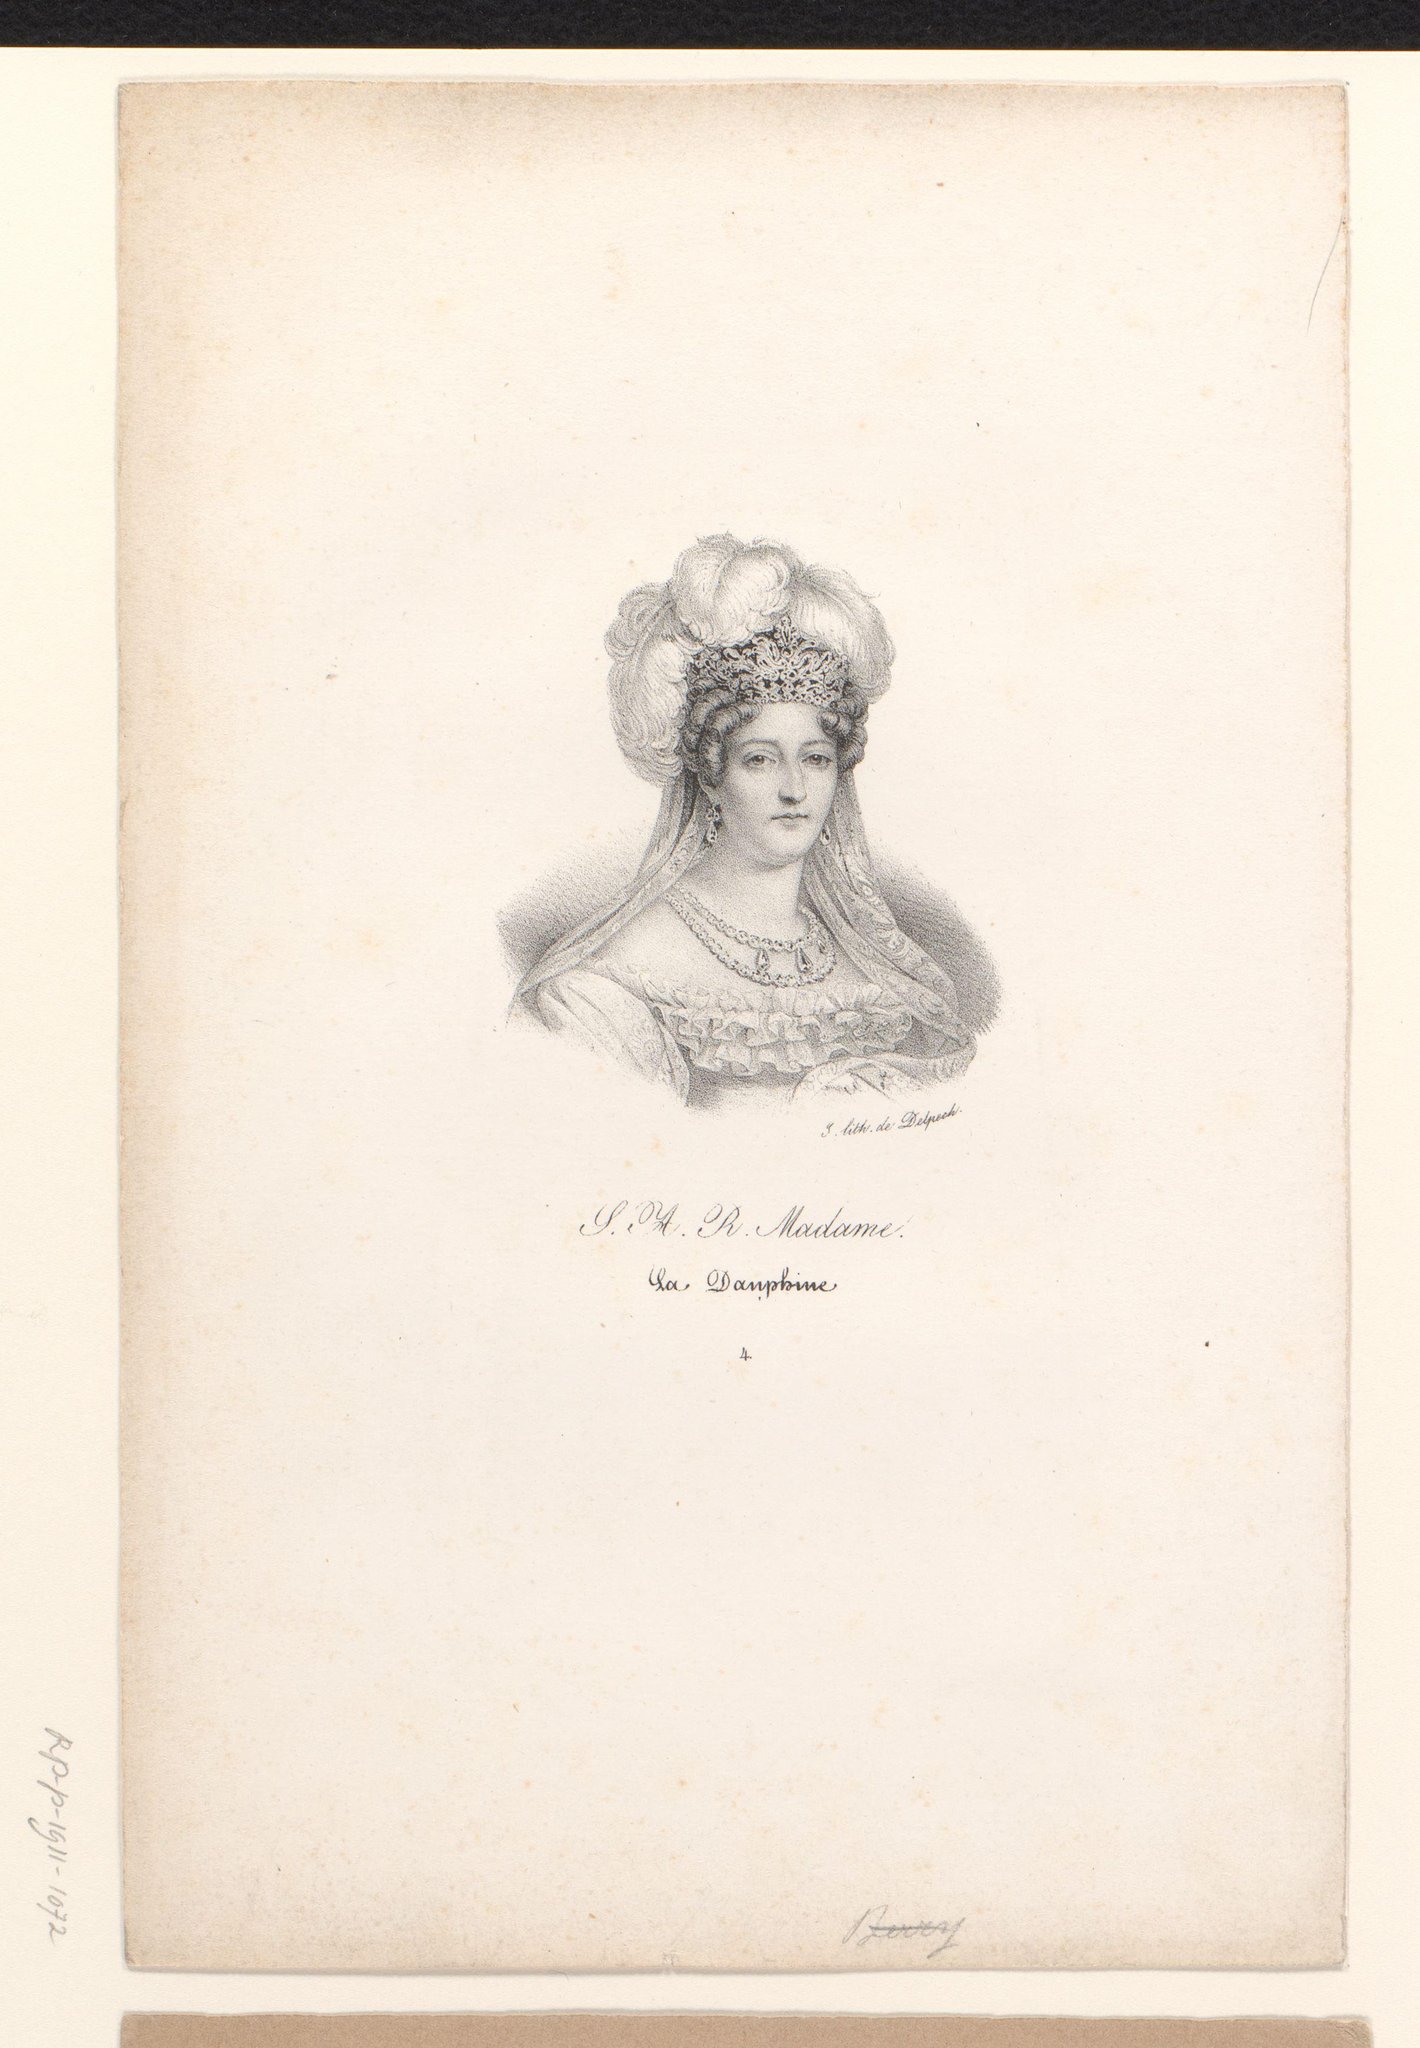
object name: print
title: Portret van Marie Thérèse Charlotte van Frankrijk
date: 1818-1842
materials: paper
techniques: lithograph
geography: paris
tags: vienna, marie thérèse charlotte van frankrijk, historical persons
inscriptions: collector's mark: Lugt 2228a